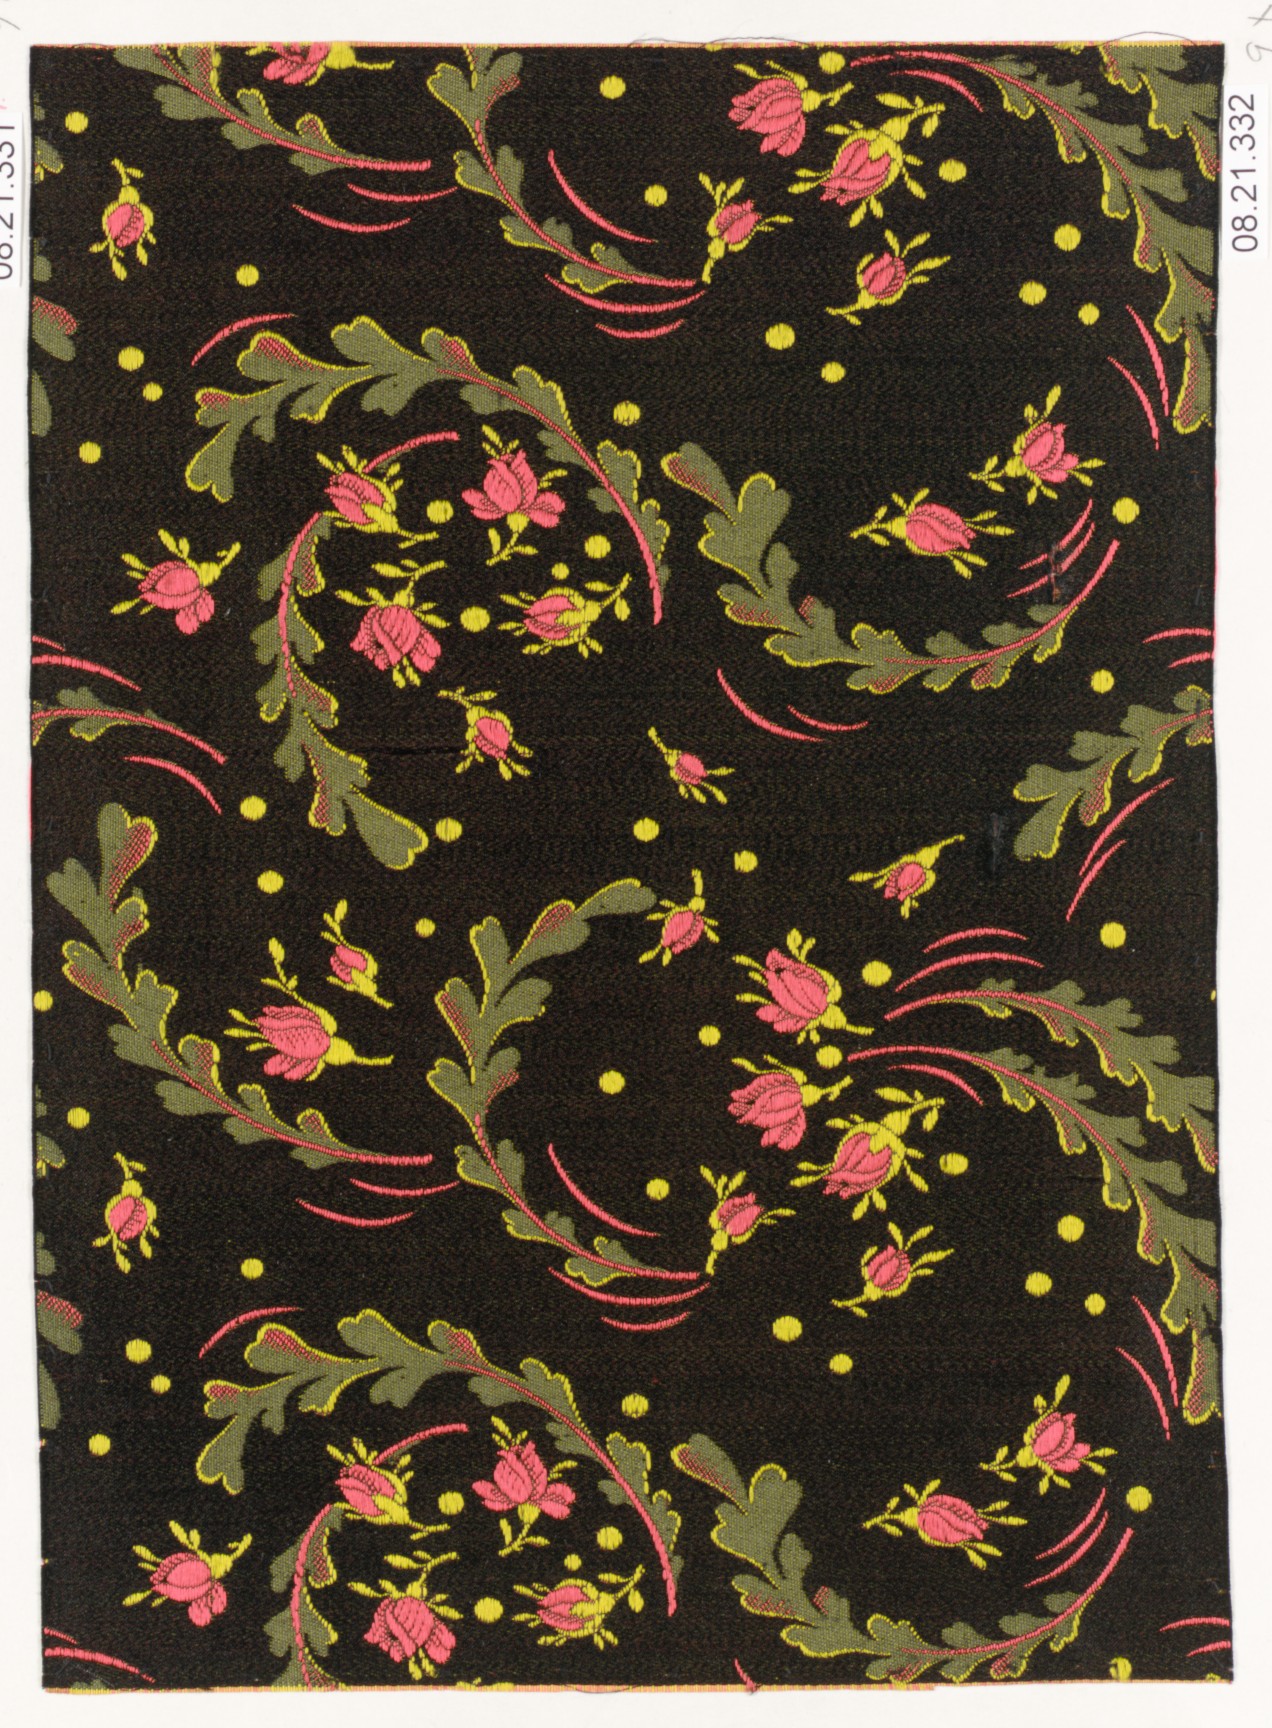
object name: textile sample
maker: Anonymous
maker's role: designer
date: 1900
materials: silk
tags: flowers,leaves